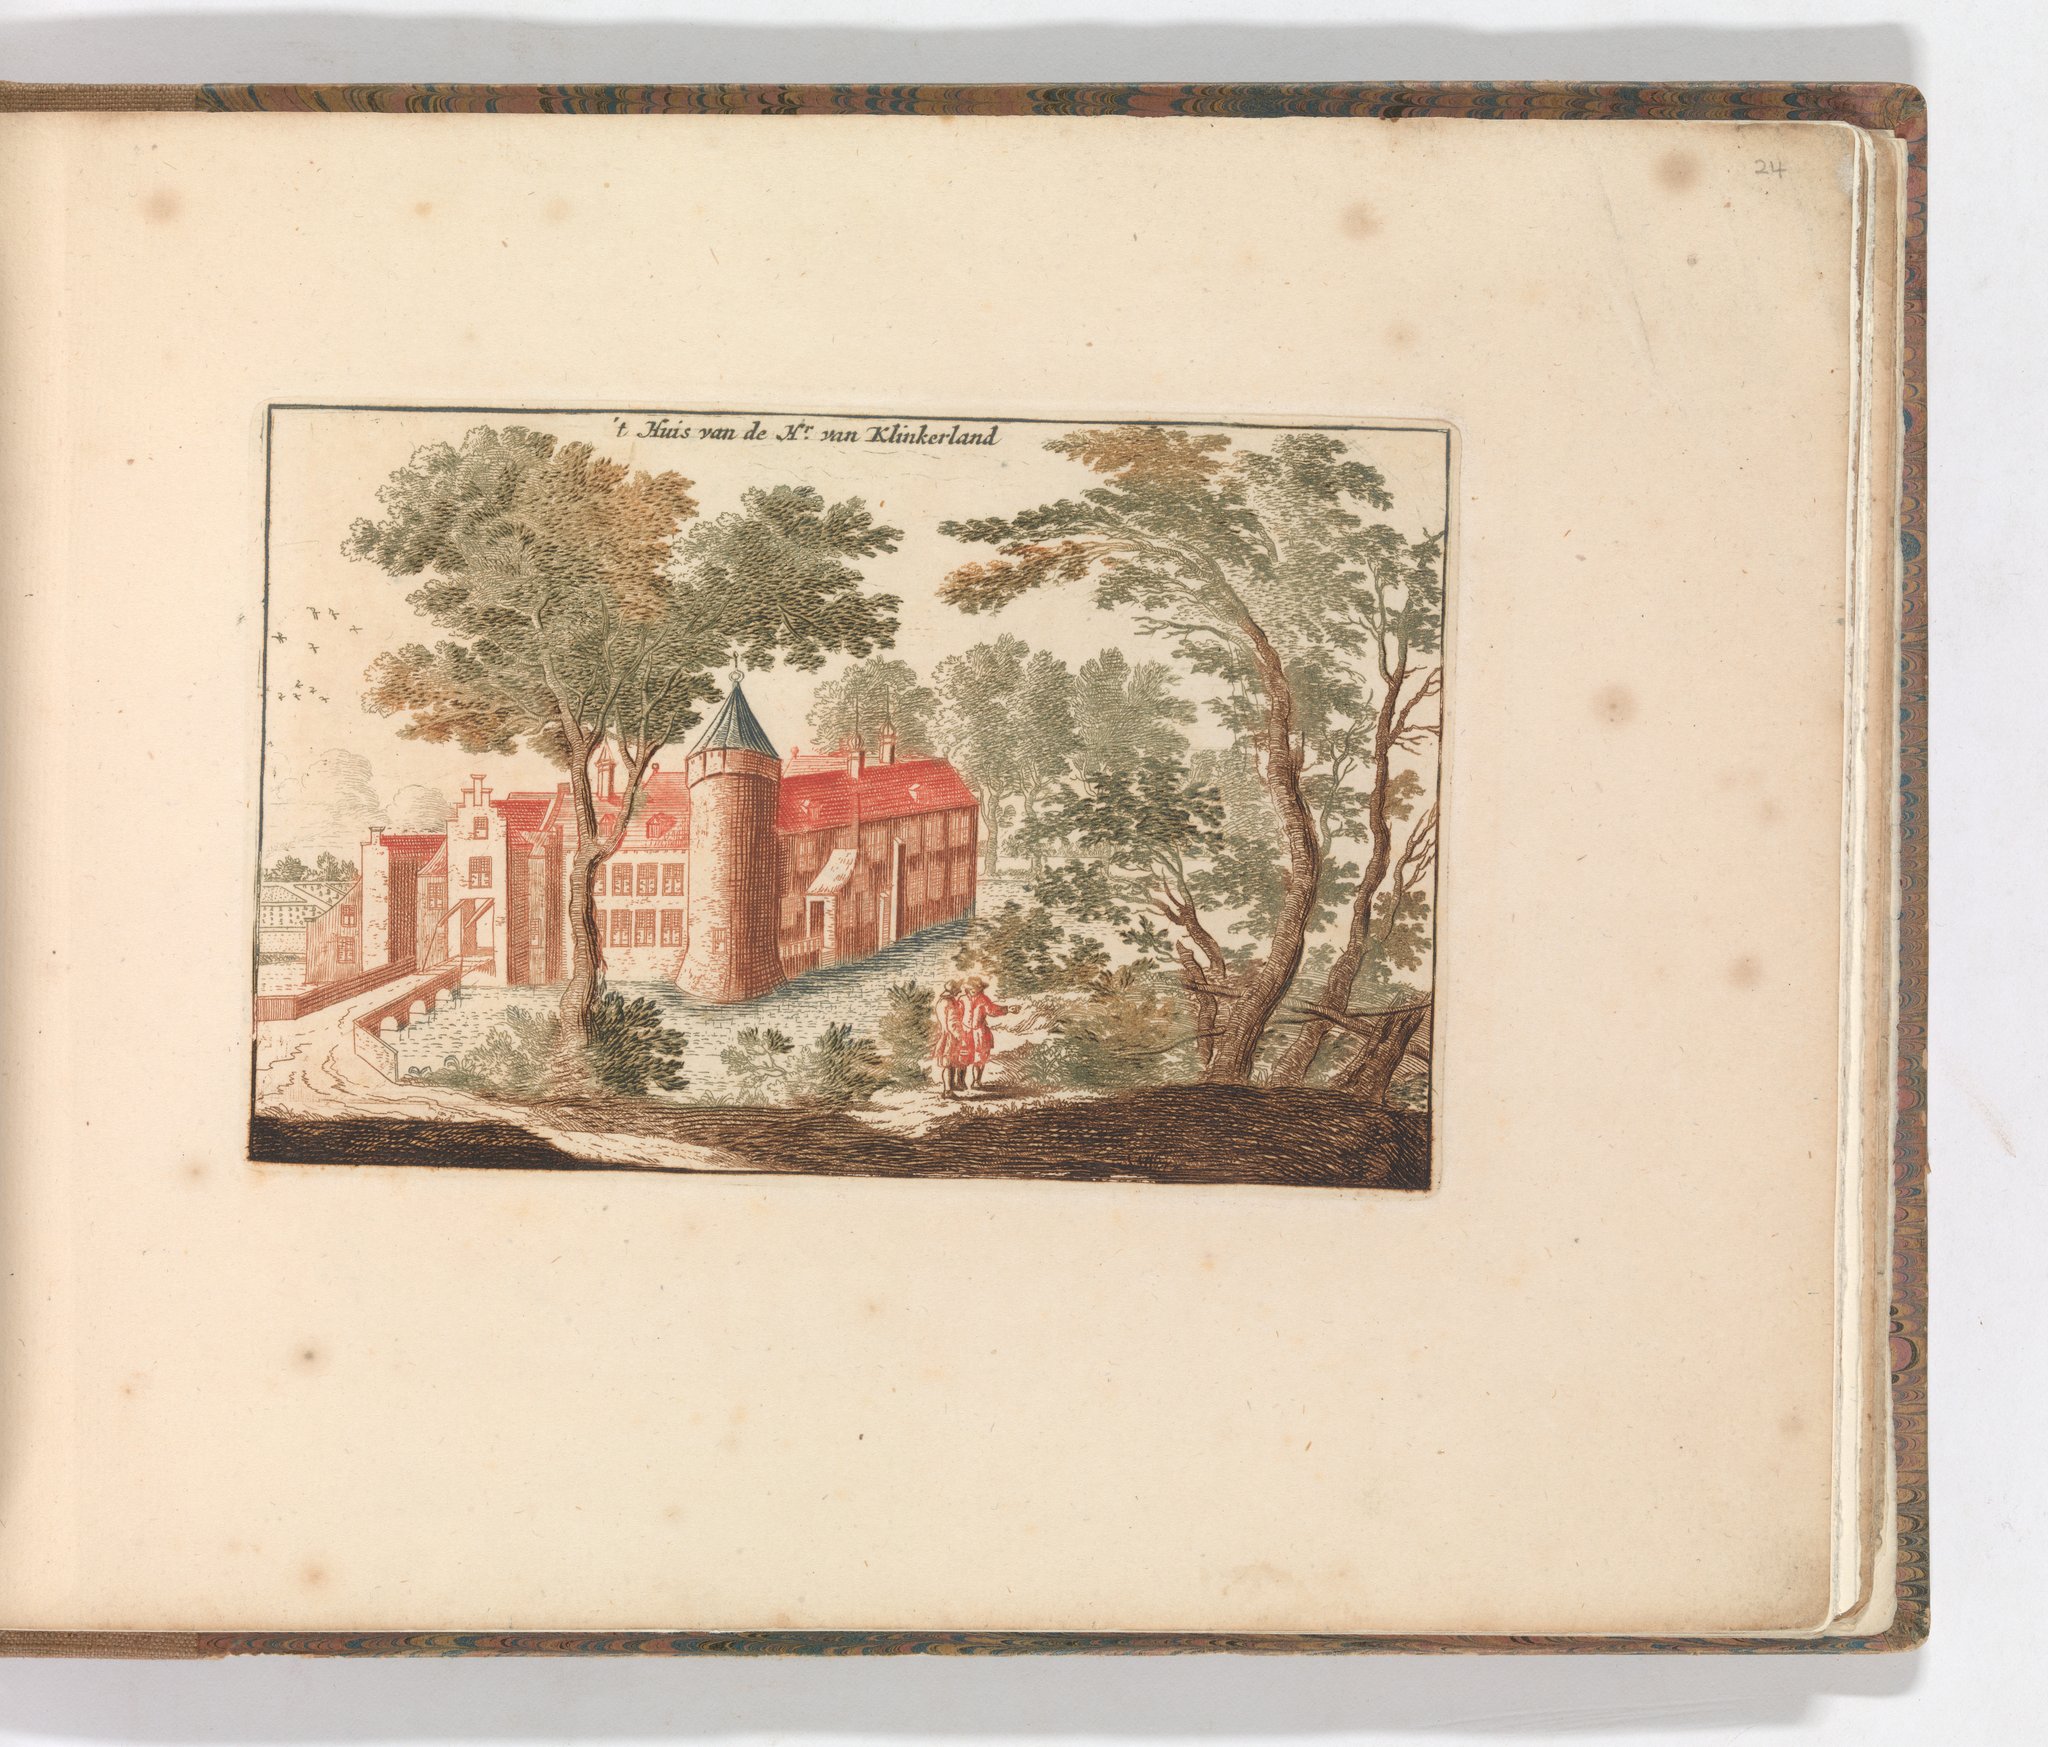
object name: book print ornament architecture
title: ' 't Huis van de Hr van Klinkerland', in: Tooneel Der Voornaamste Nederlands Huizen, En Lust Hoven, Naar T Leven Afgebeeld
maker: carel allard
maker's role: publisher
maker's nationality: dutch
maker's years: 1648-1709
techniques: engraving, lithography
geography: amsterdam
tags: buildings,landscapes